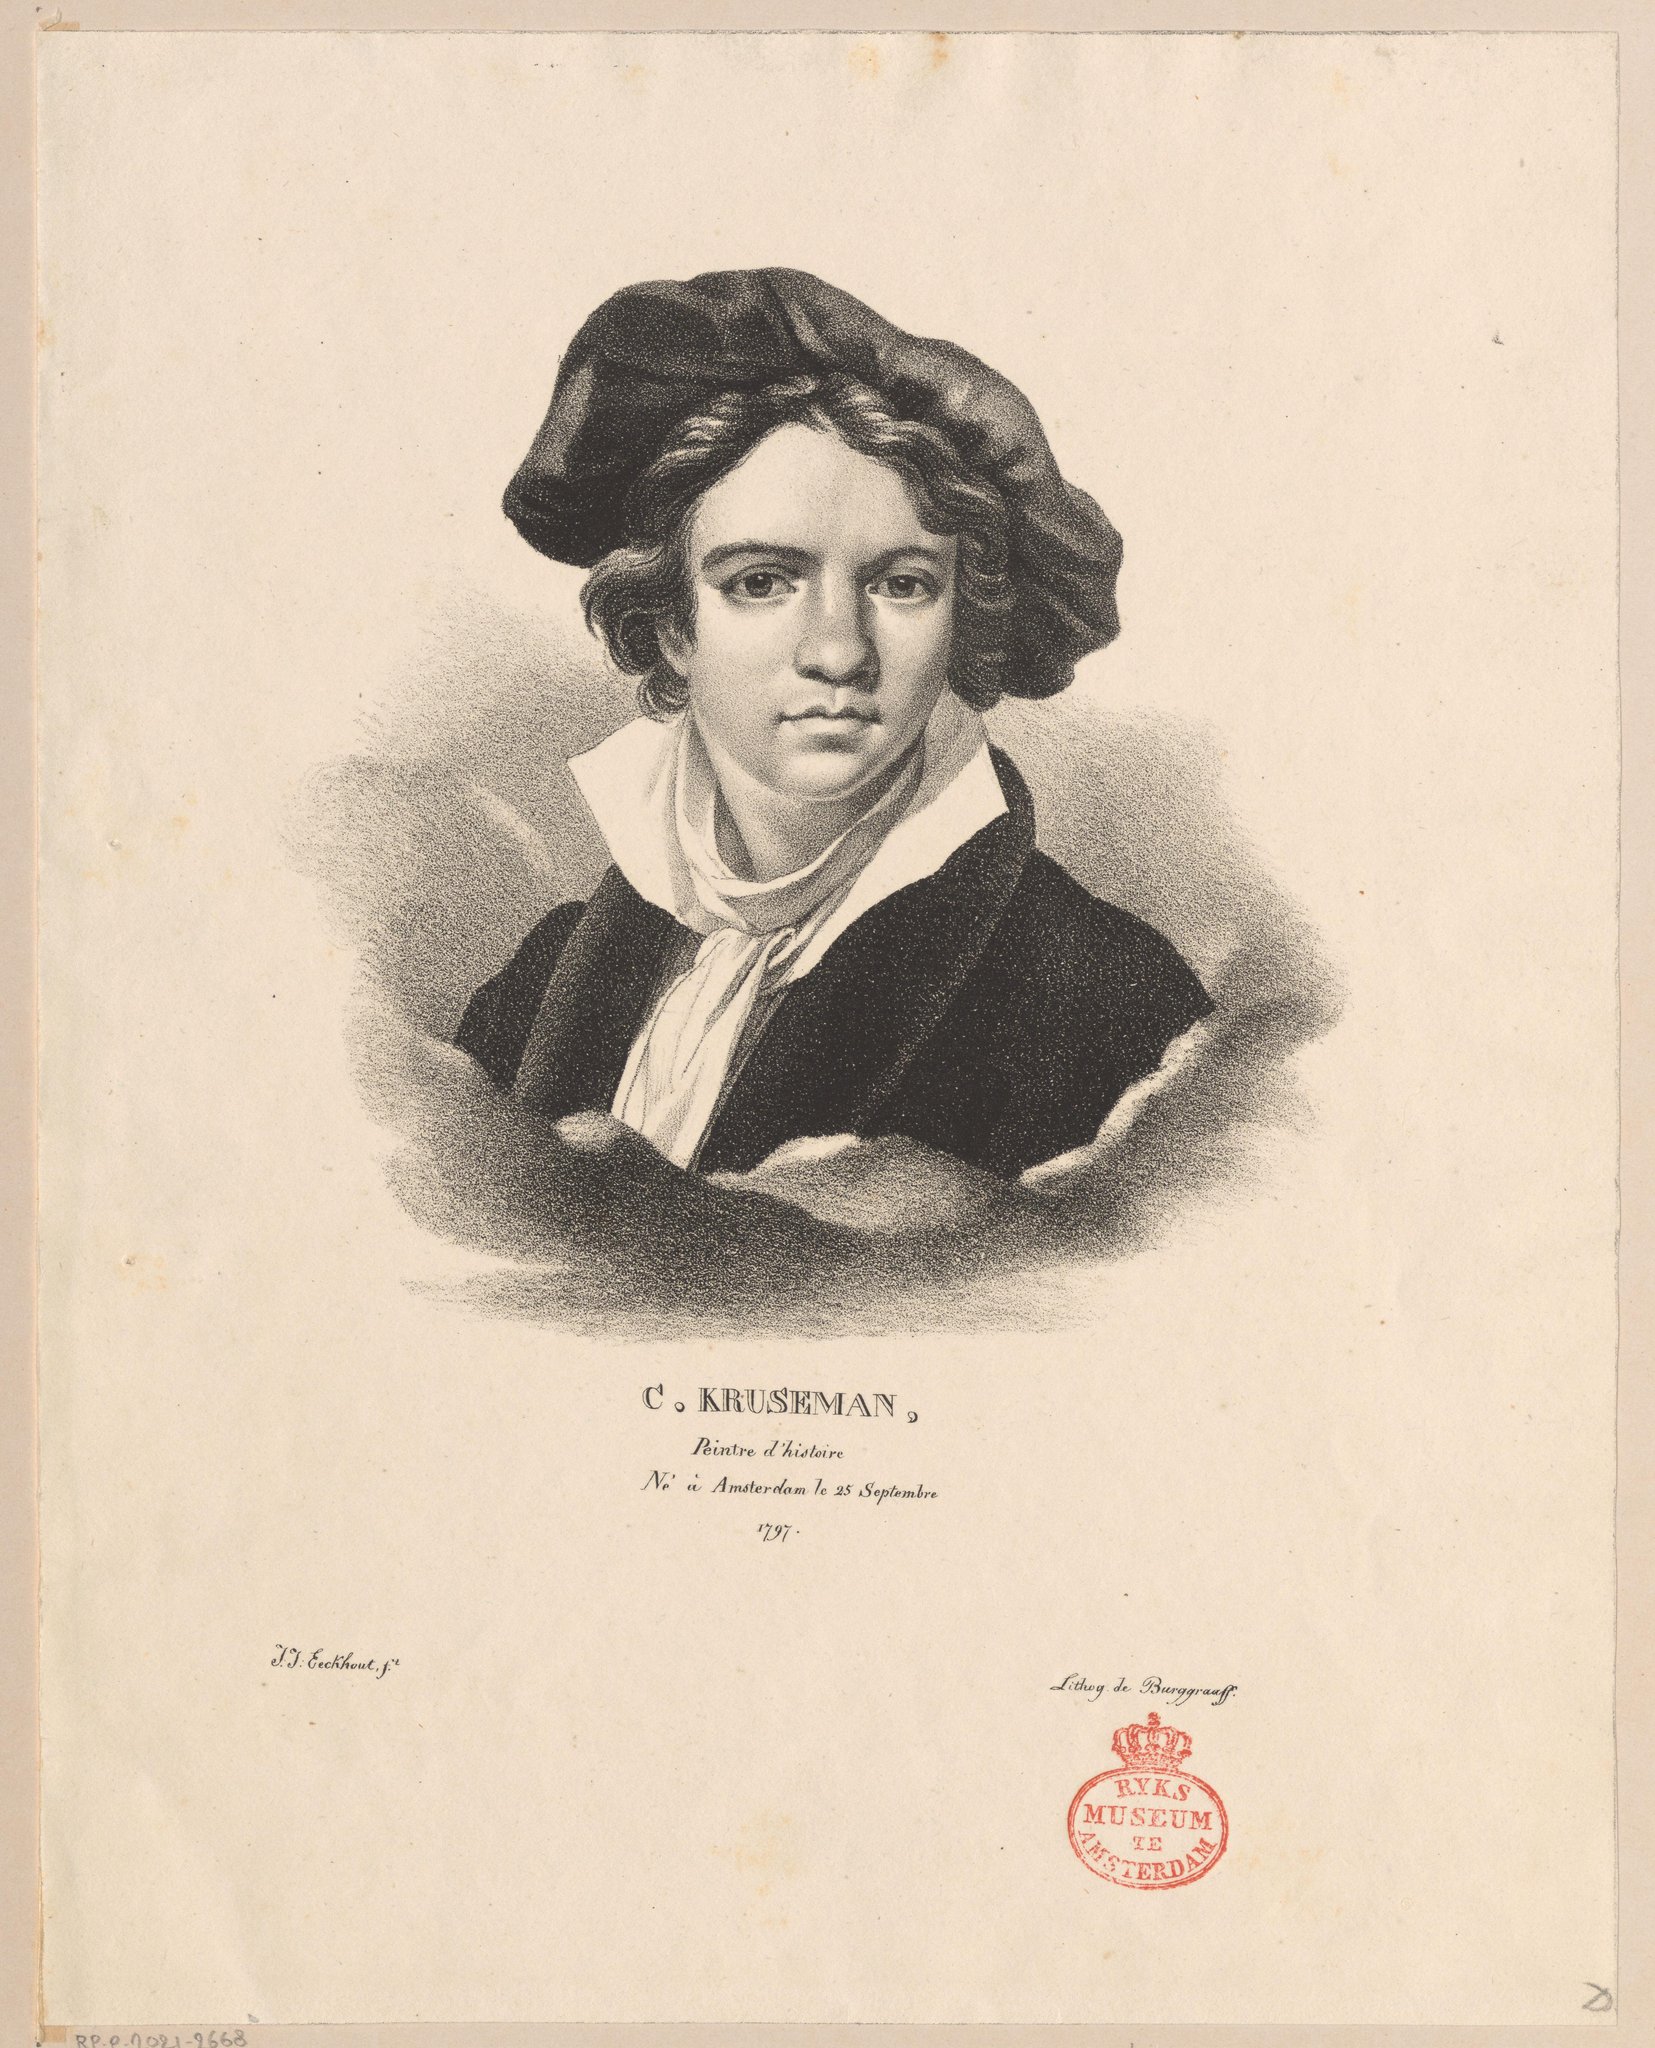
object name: print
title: Portret van Cornelis Kruseman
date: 1807-1899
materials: paper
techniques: lithograph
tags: amsterdam, painter, print maker, draughtsman, cornelis kruseman, historical persons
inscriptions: collector's mark: Lugt 12